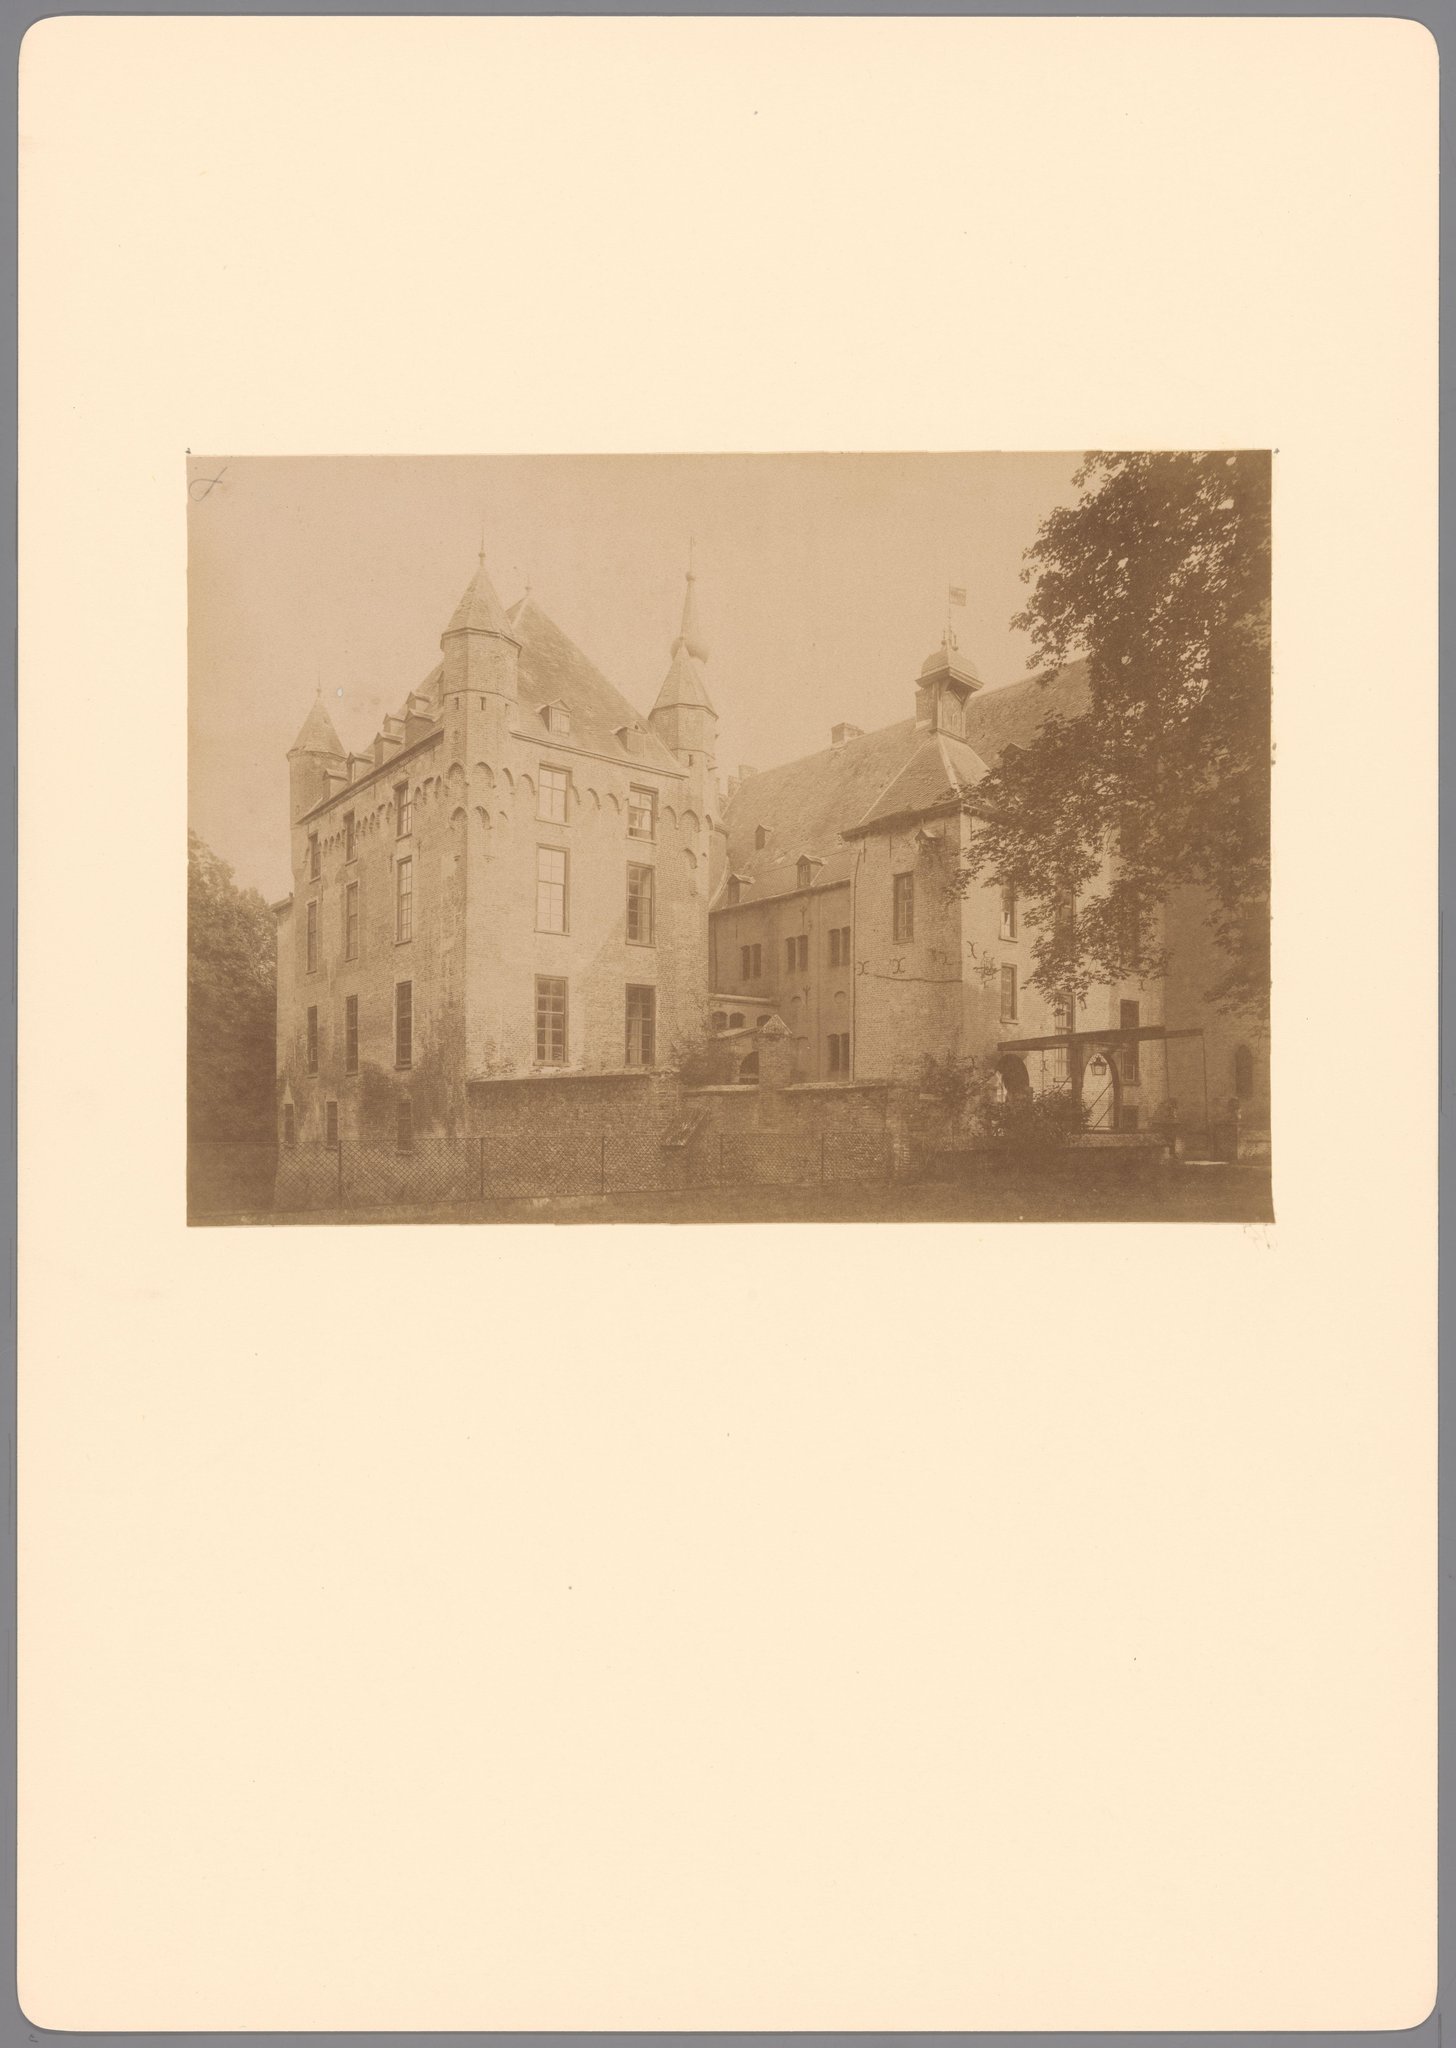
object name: photograph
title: Gezicht op Kasteel Doorwerth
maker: anoniem (monumentenzorg)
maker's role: fotograaf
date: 1890-1920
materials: cardboard, photographic support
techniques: albumen print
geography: kasteel doorwerth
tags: castle, landscape with tower or castle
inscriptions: annotation: ‘Kasteel Doorwerth’, annotation: ‘j’